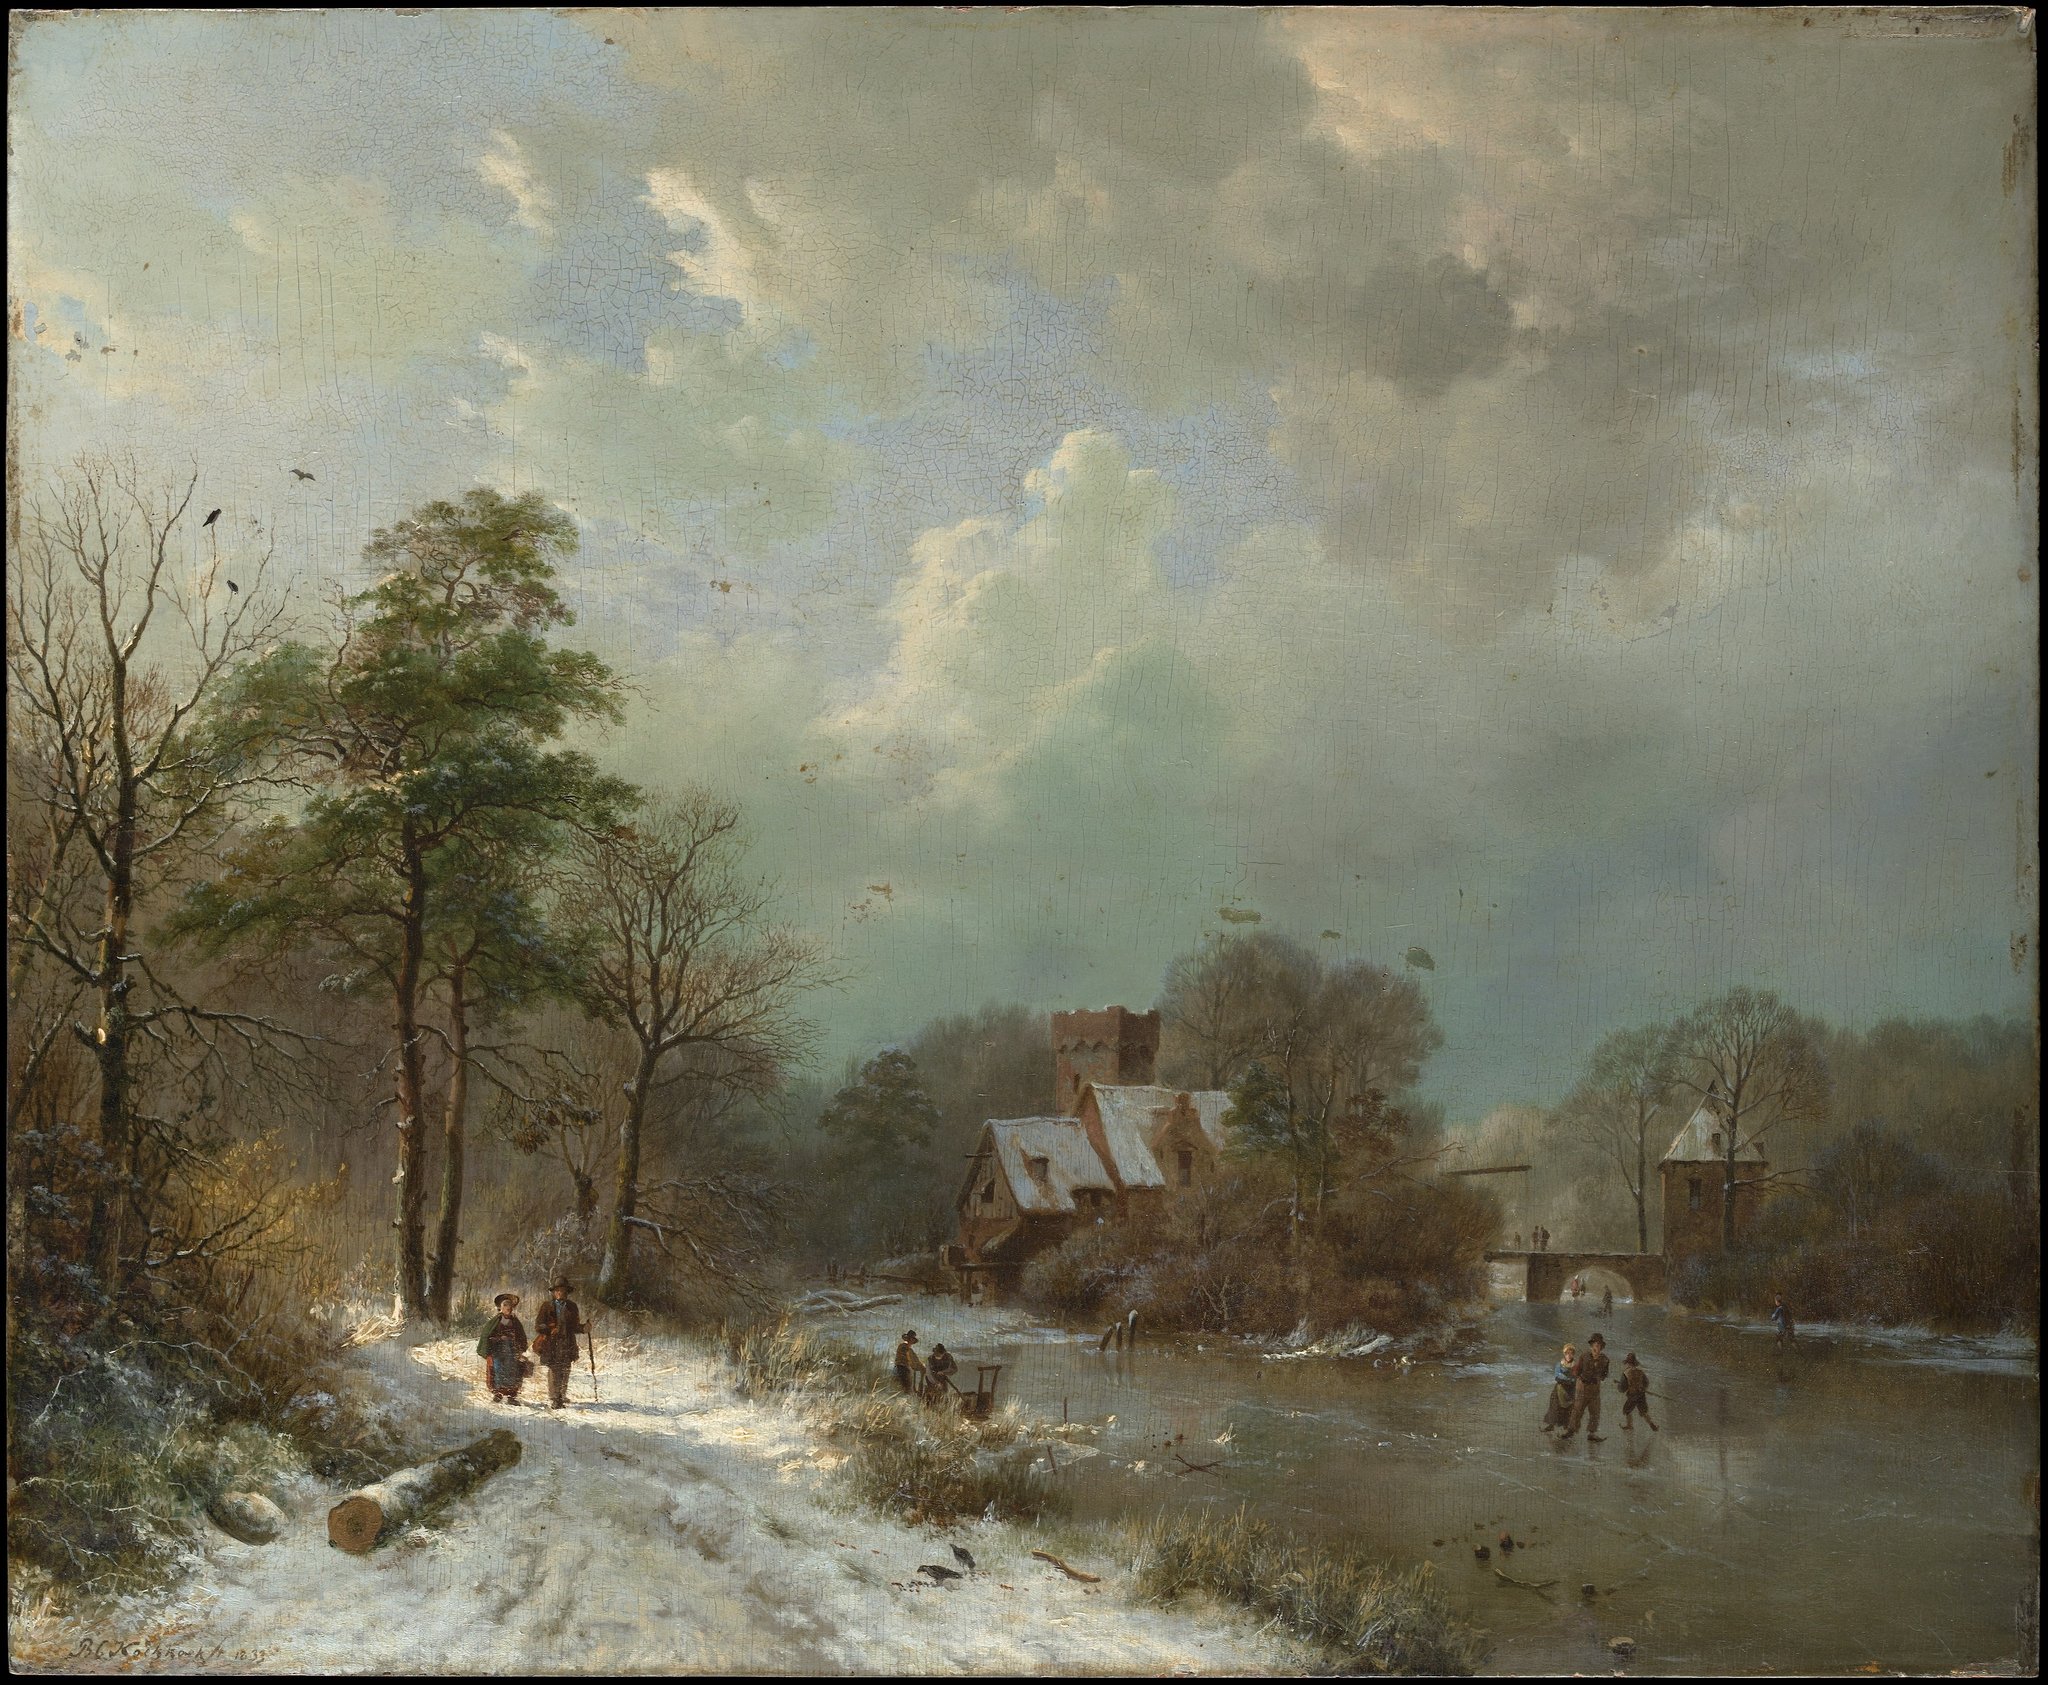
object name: painting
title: Winter Landscape, Holland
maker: barend cornelis koekkoek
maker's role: artist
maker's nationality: dutch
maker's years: 1803-1862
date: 1833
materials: oil, wood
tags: skating,landscapes,winter,snow